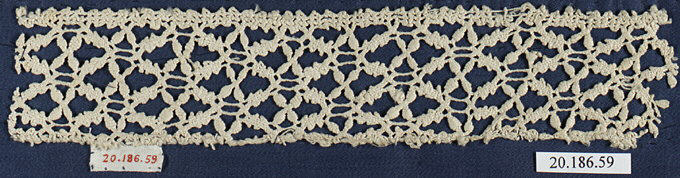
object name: strip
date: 1501-1600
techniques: lace